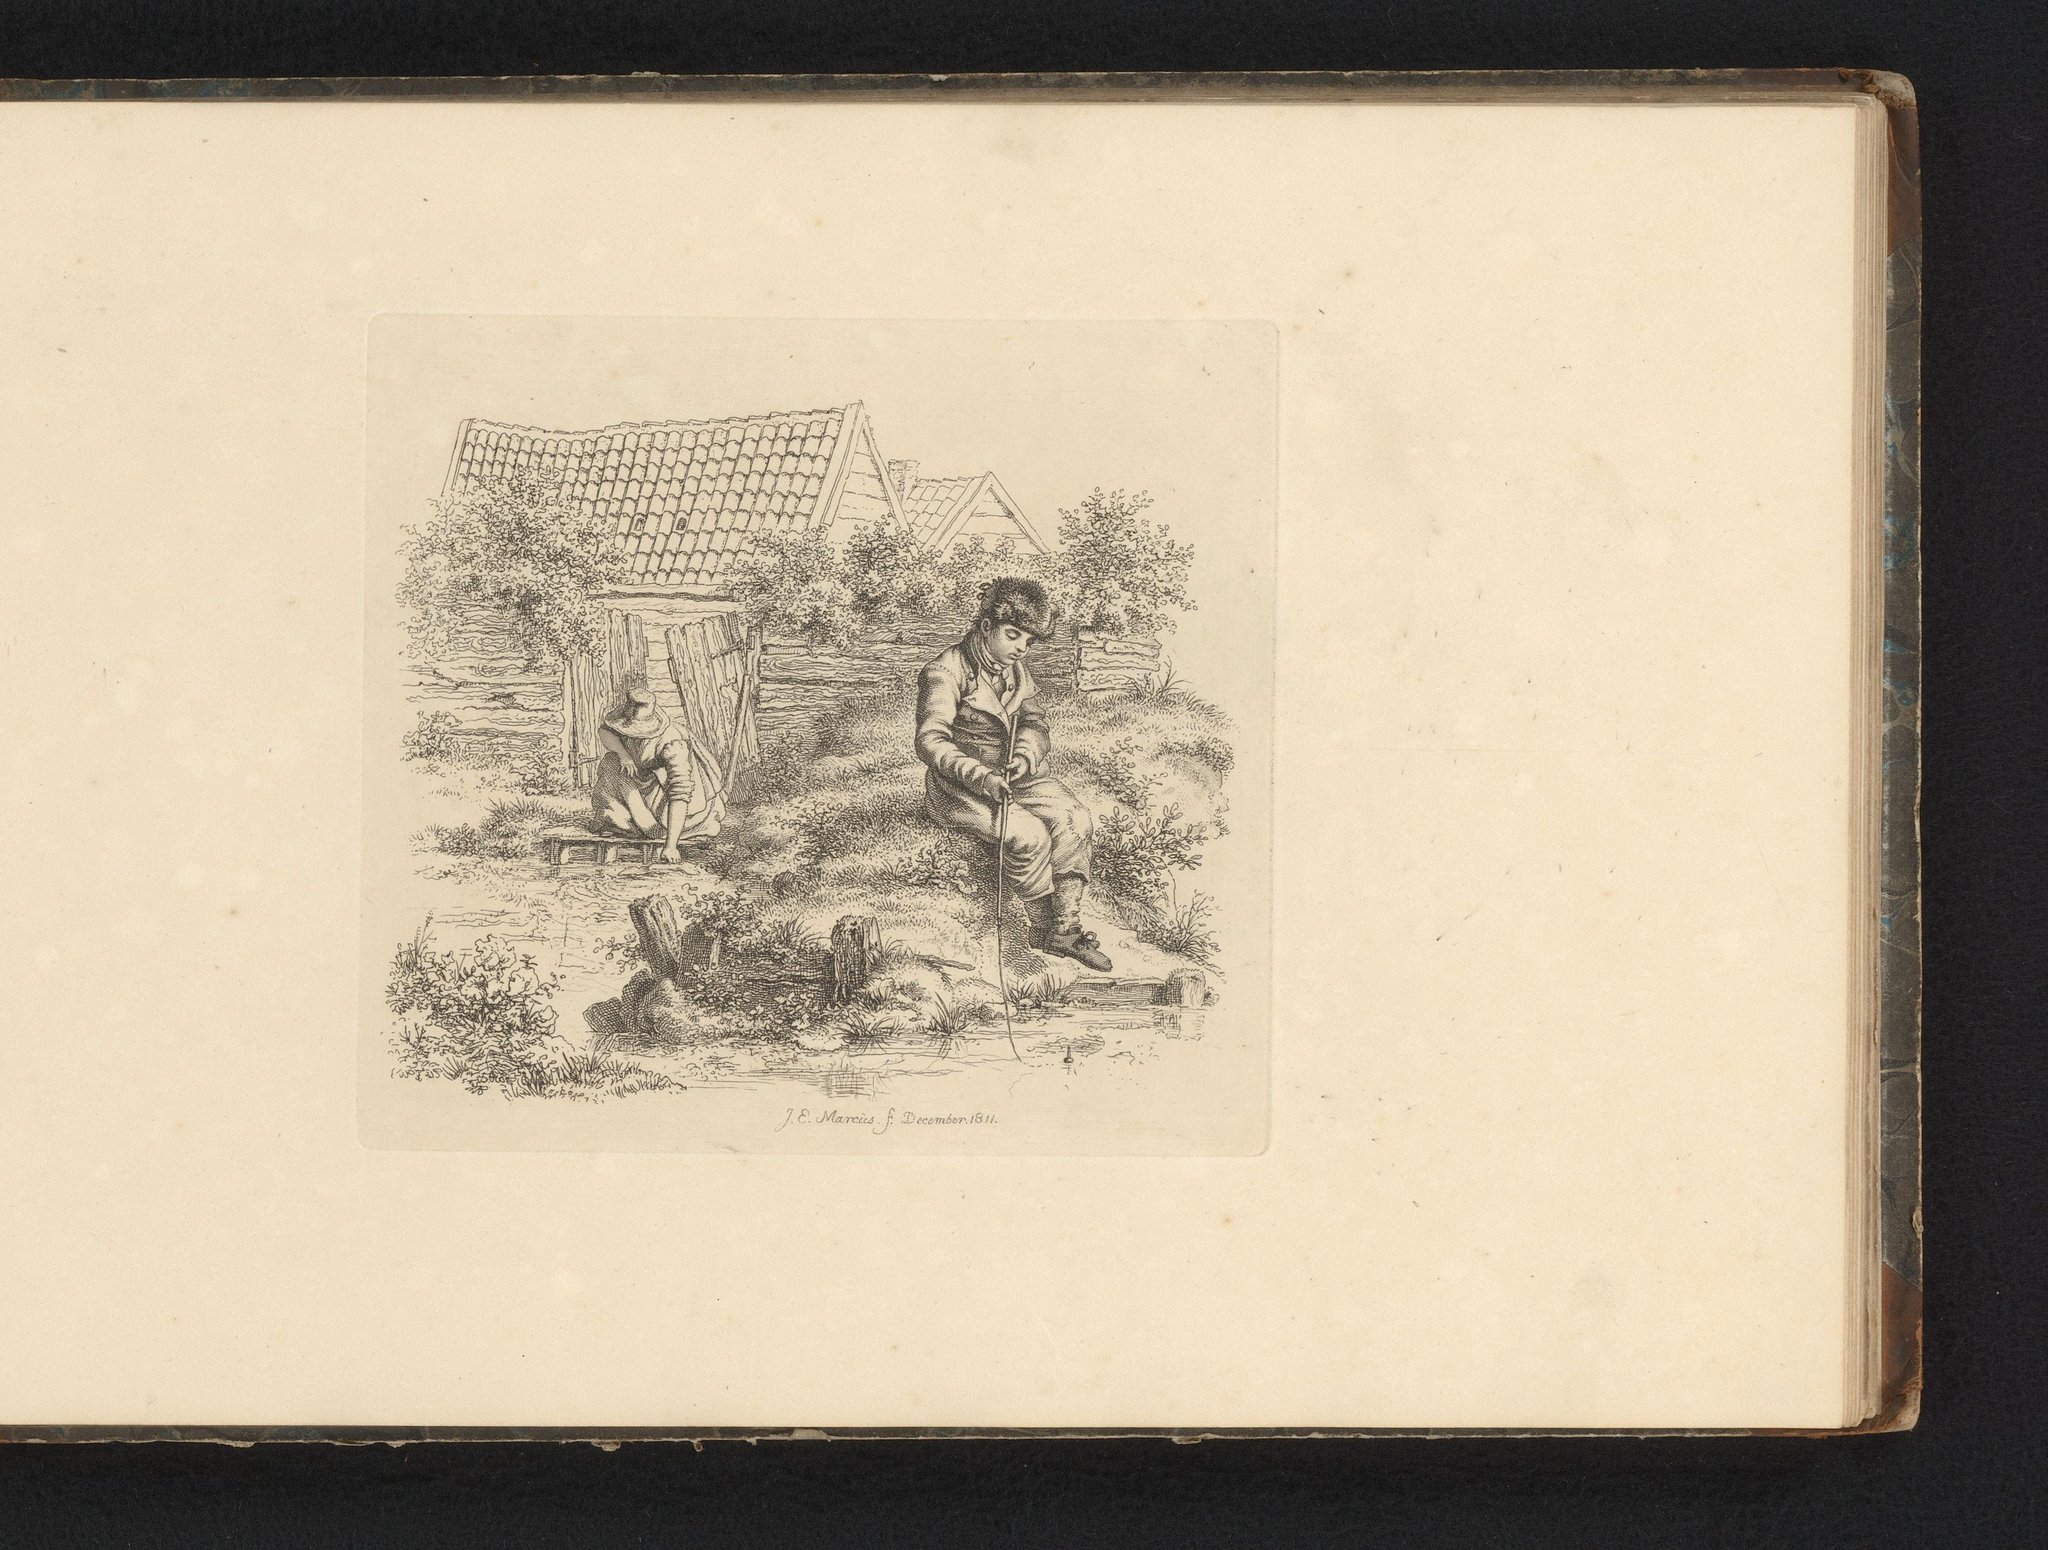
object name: album leaf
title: Vissende jongeman en knielende vrouw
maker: jacob ernst marcus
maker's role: draughtsman, print maker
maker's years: 1774-1826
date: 1811-1812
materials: paper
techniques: etching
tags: laundering, farm or solitary house in landscape, angling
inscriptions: date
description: Deze prent maakt deel uit van een album.